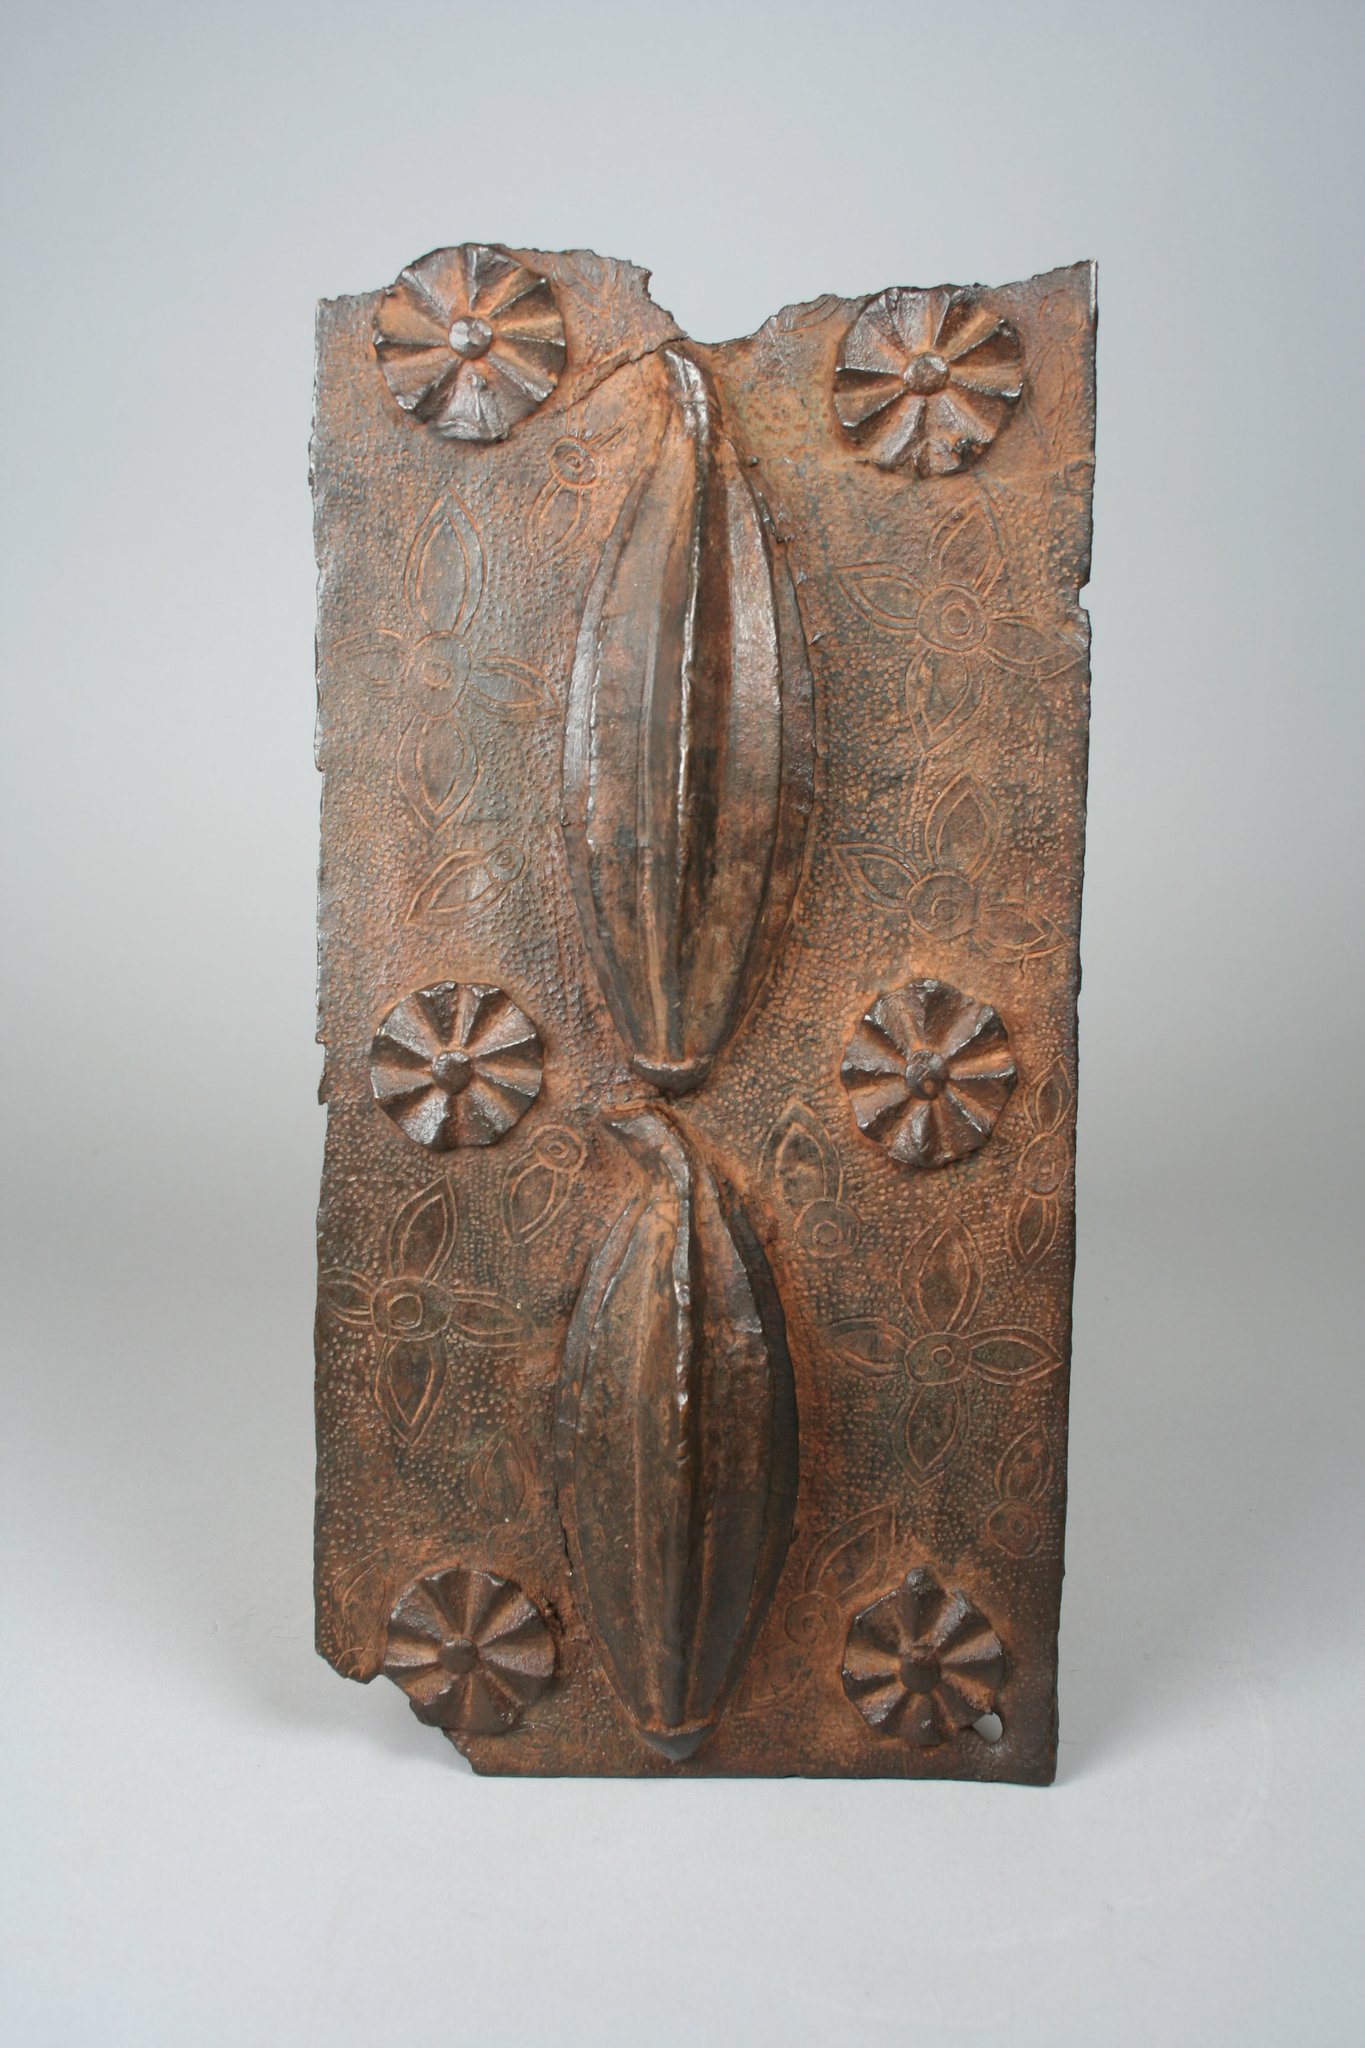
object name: plaque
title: Plaque with Two Fluted Gourds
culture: edo period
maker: ìgùn ẹ́rọ̀nwwọ̀n (brass-casting guild) artists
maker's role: artist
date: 1540-1570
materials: brass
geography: nigeria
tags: gourds